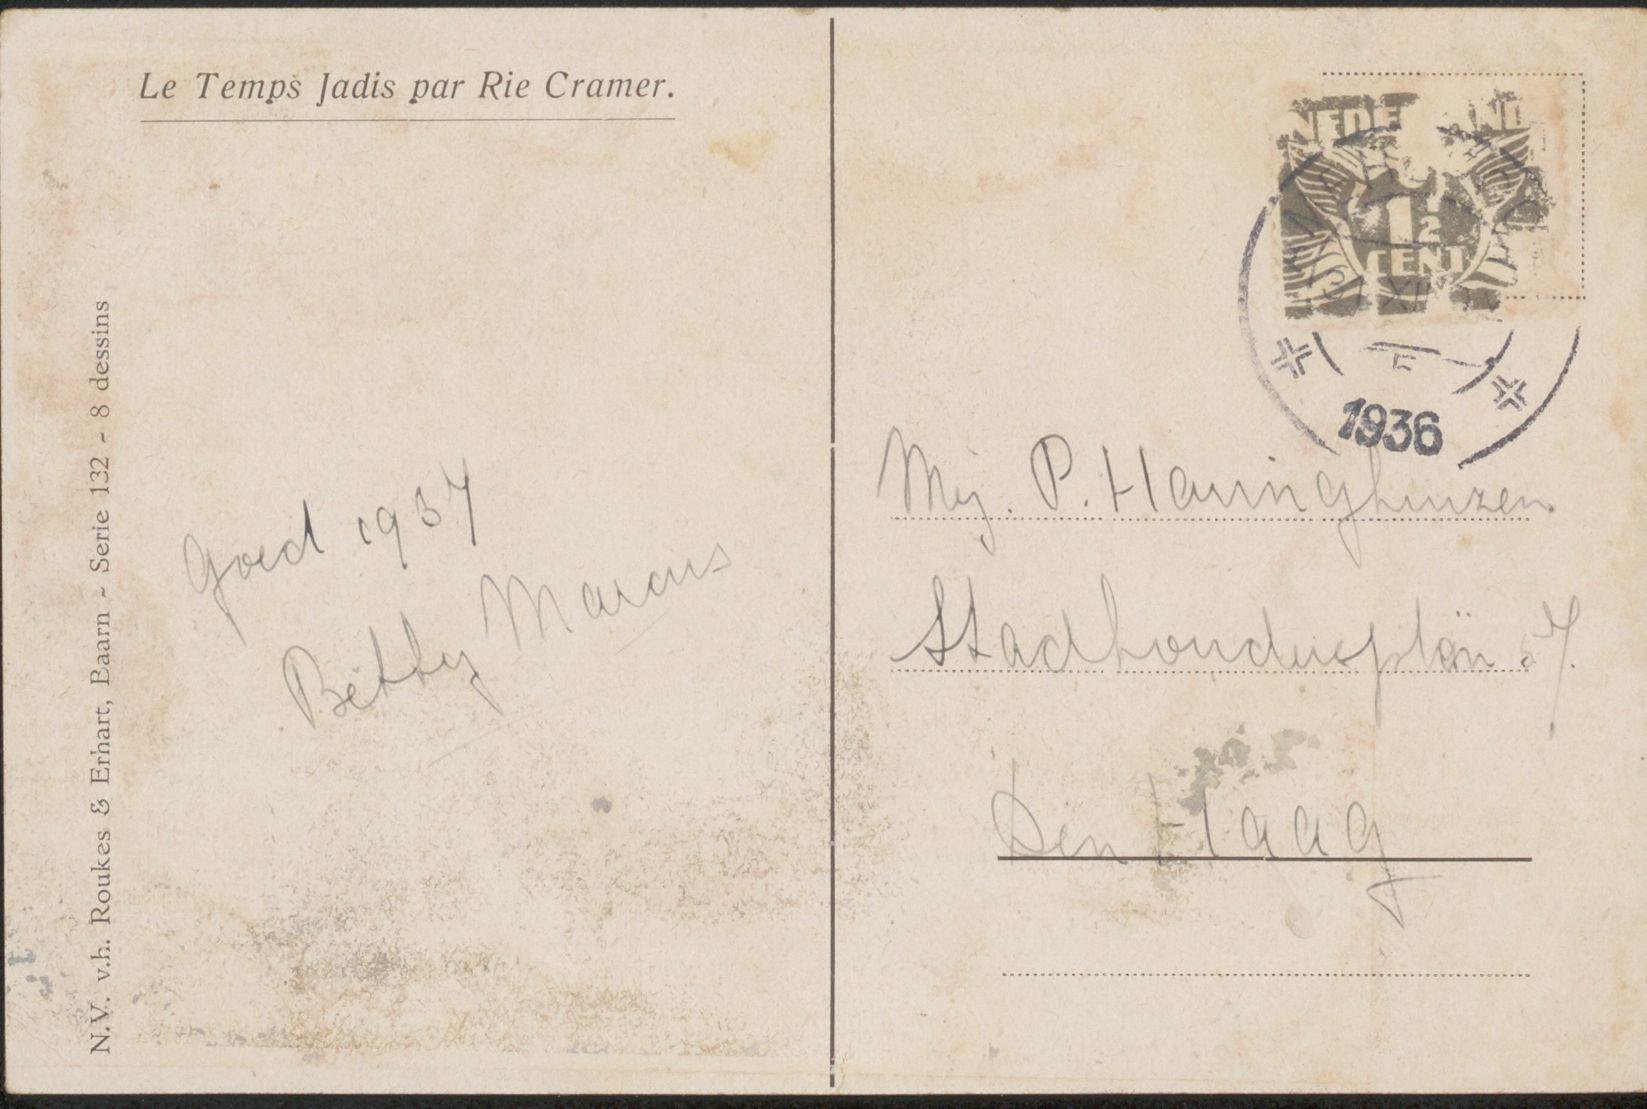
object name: ansichtkaart, prentbriefkaart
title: Prentbriefkaart aan P. Haringhuizen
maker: betty marcus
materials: cardboard, ink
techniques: pen, writing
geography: amersfoort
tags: p. haringhuizen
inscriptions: collector's mark: ‘RPK’